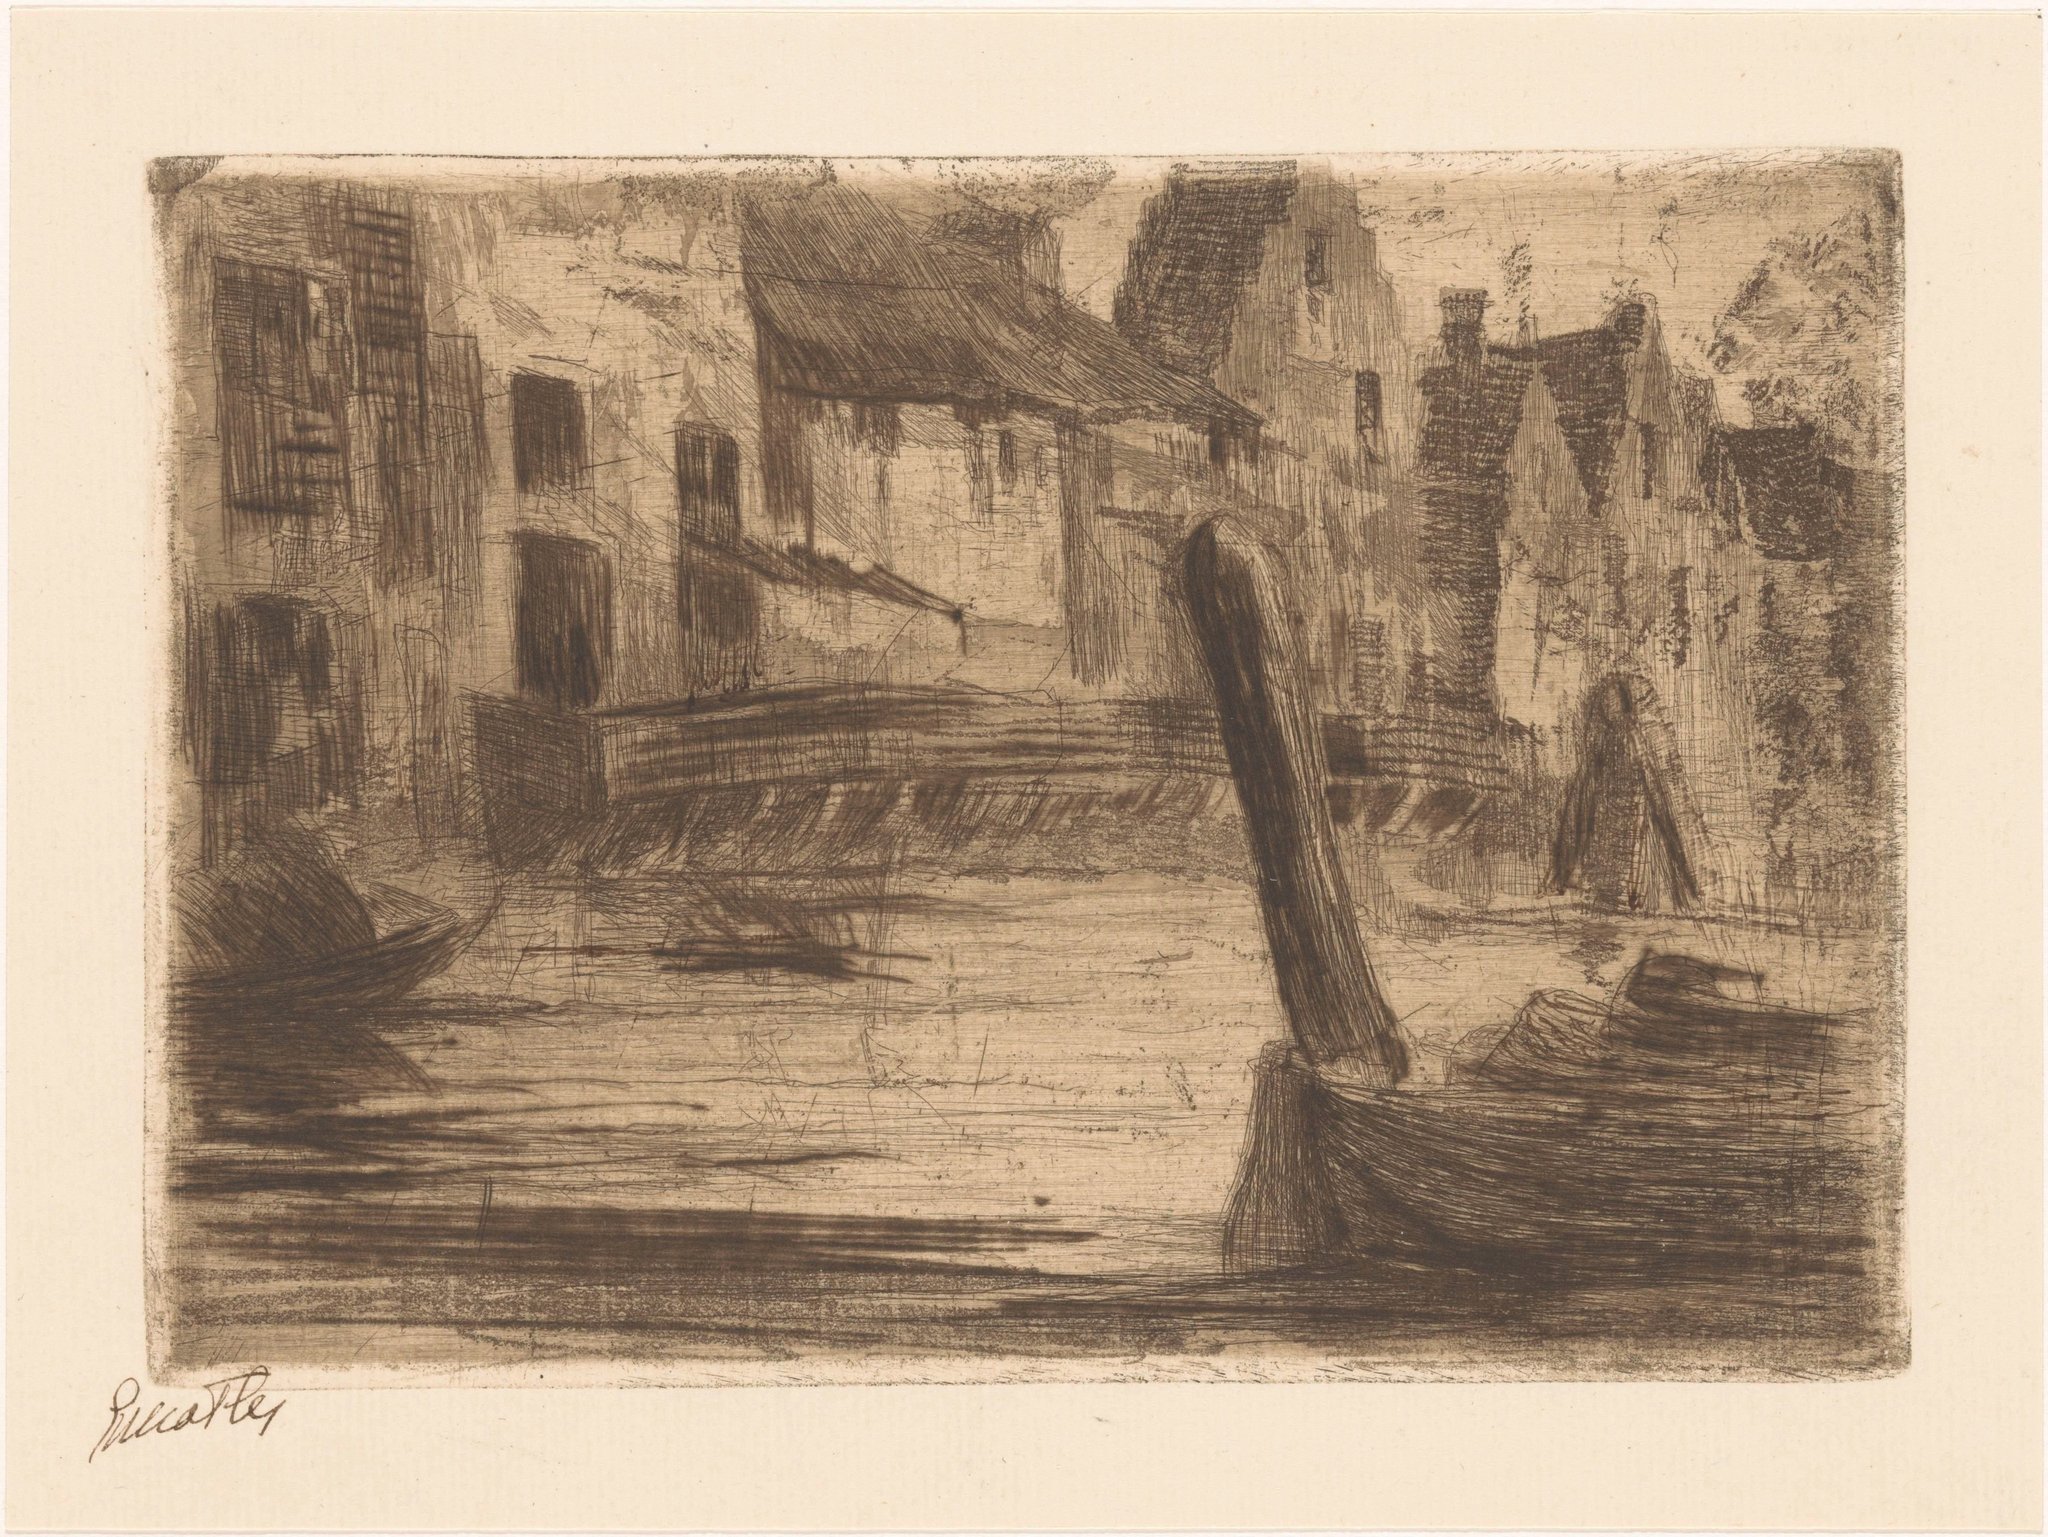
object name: print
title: Dordrecht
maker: etha fles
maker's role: print maker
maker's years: 1857-1948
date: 1867-1910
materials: paper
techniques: drypoint, intaglio, roulette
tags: urban housing, canals, waters (in city), dordrecht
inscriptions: collector's mark: Lugt 2228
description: Afgemeerde schepen in Dordrecht. Op de achtergrond een rij huizen aan het water.